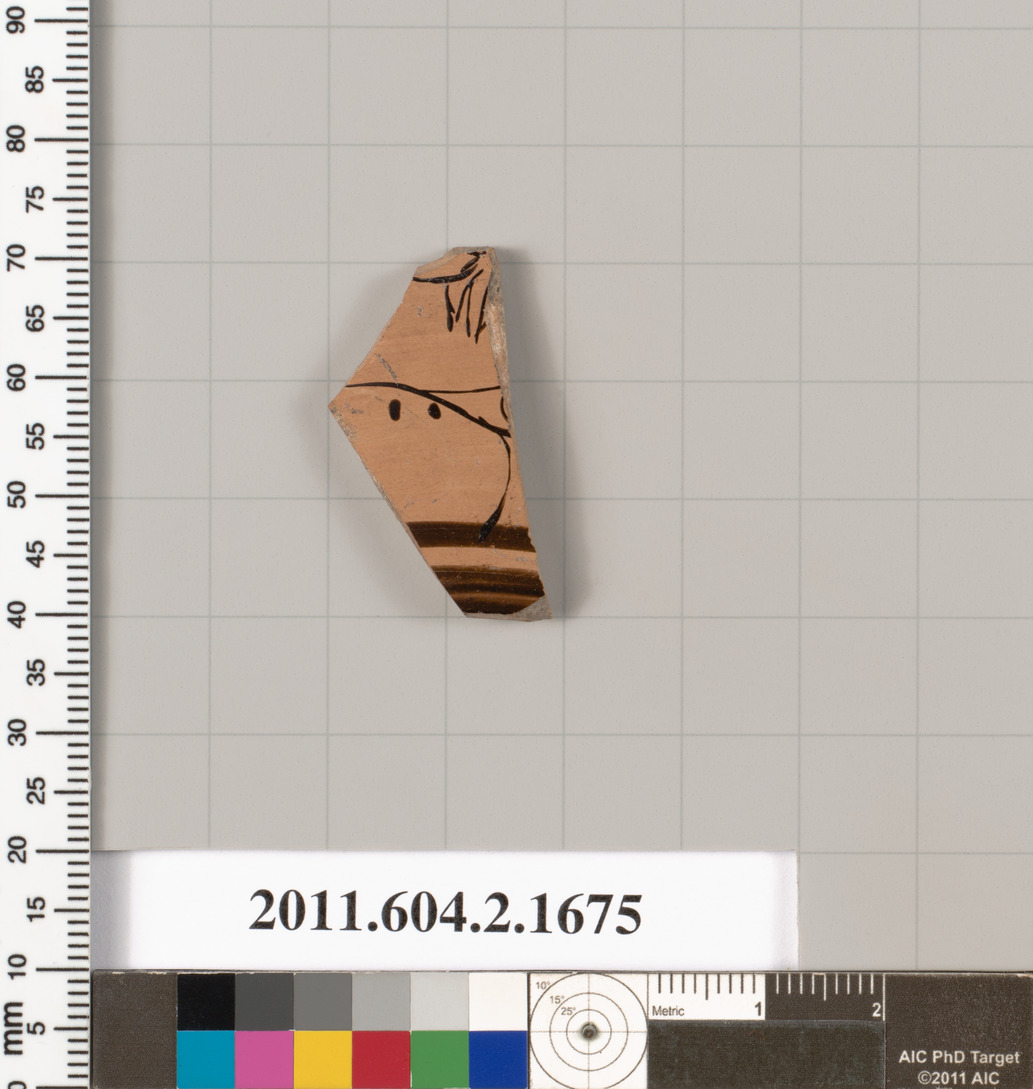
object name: skyphos fragment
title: Terracotta fragment of a skyphos (deep drinking cup)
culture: greek, attic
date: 460-440 BCE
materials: terracotta